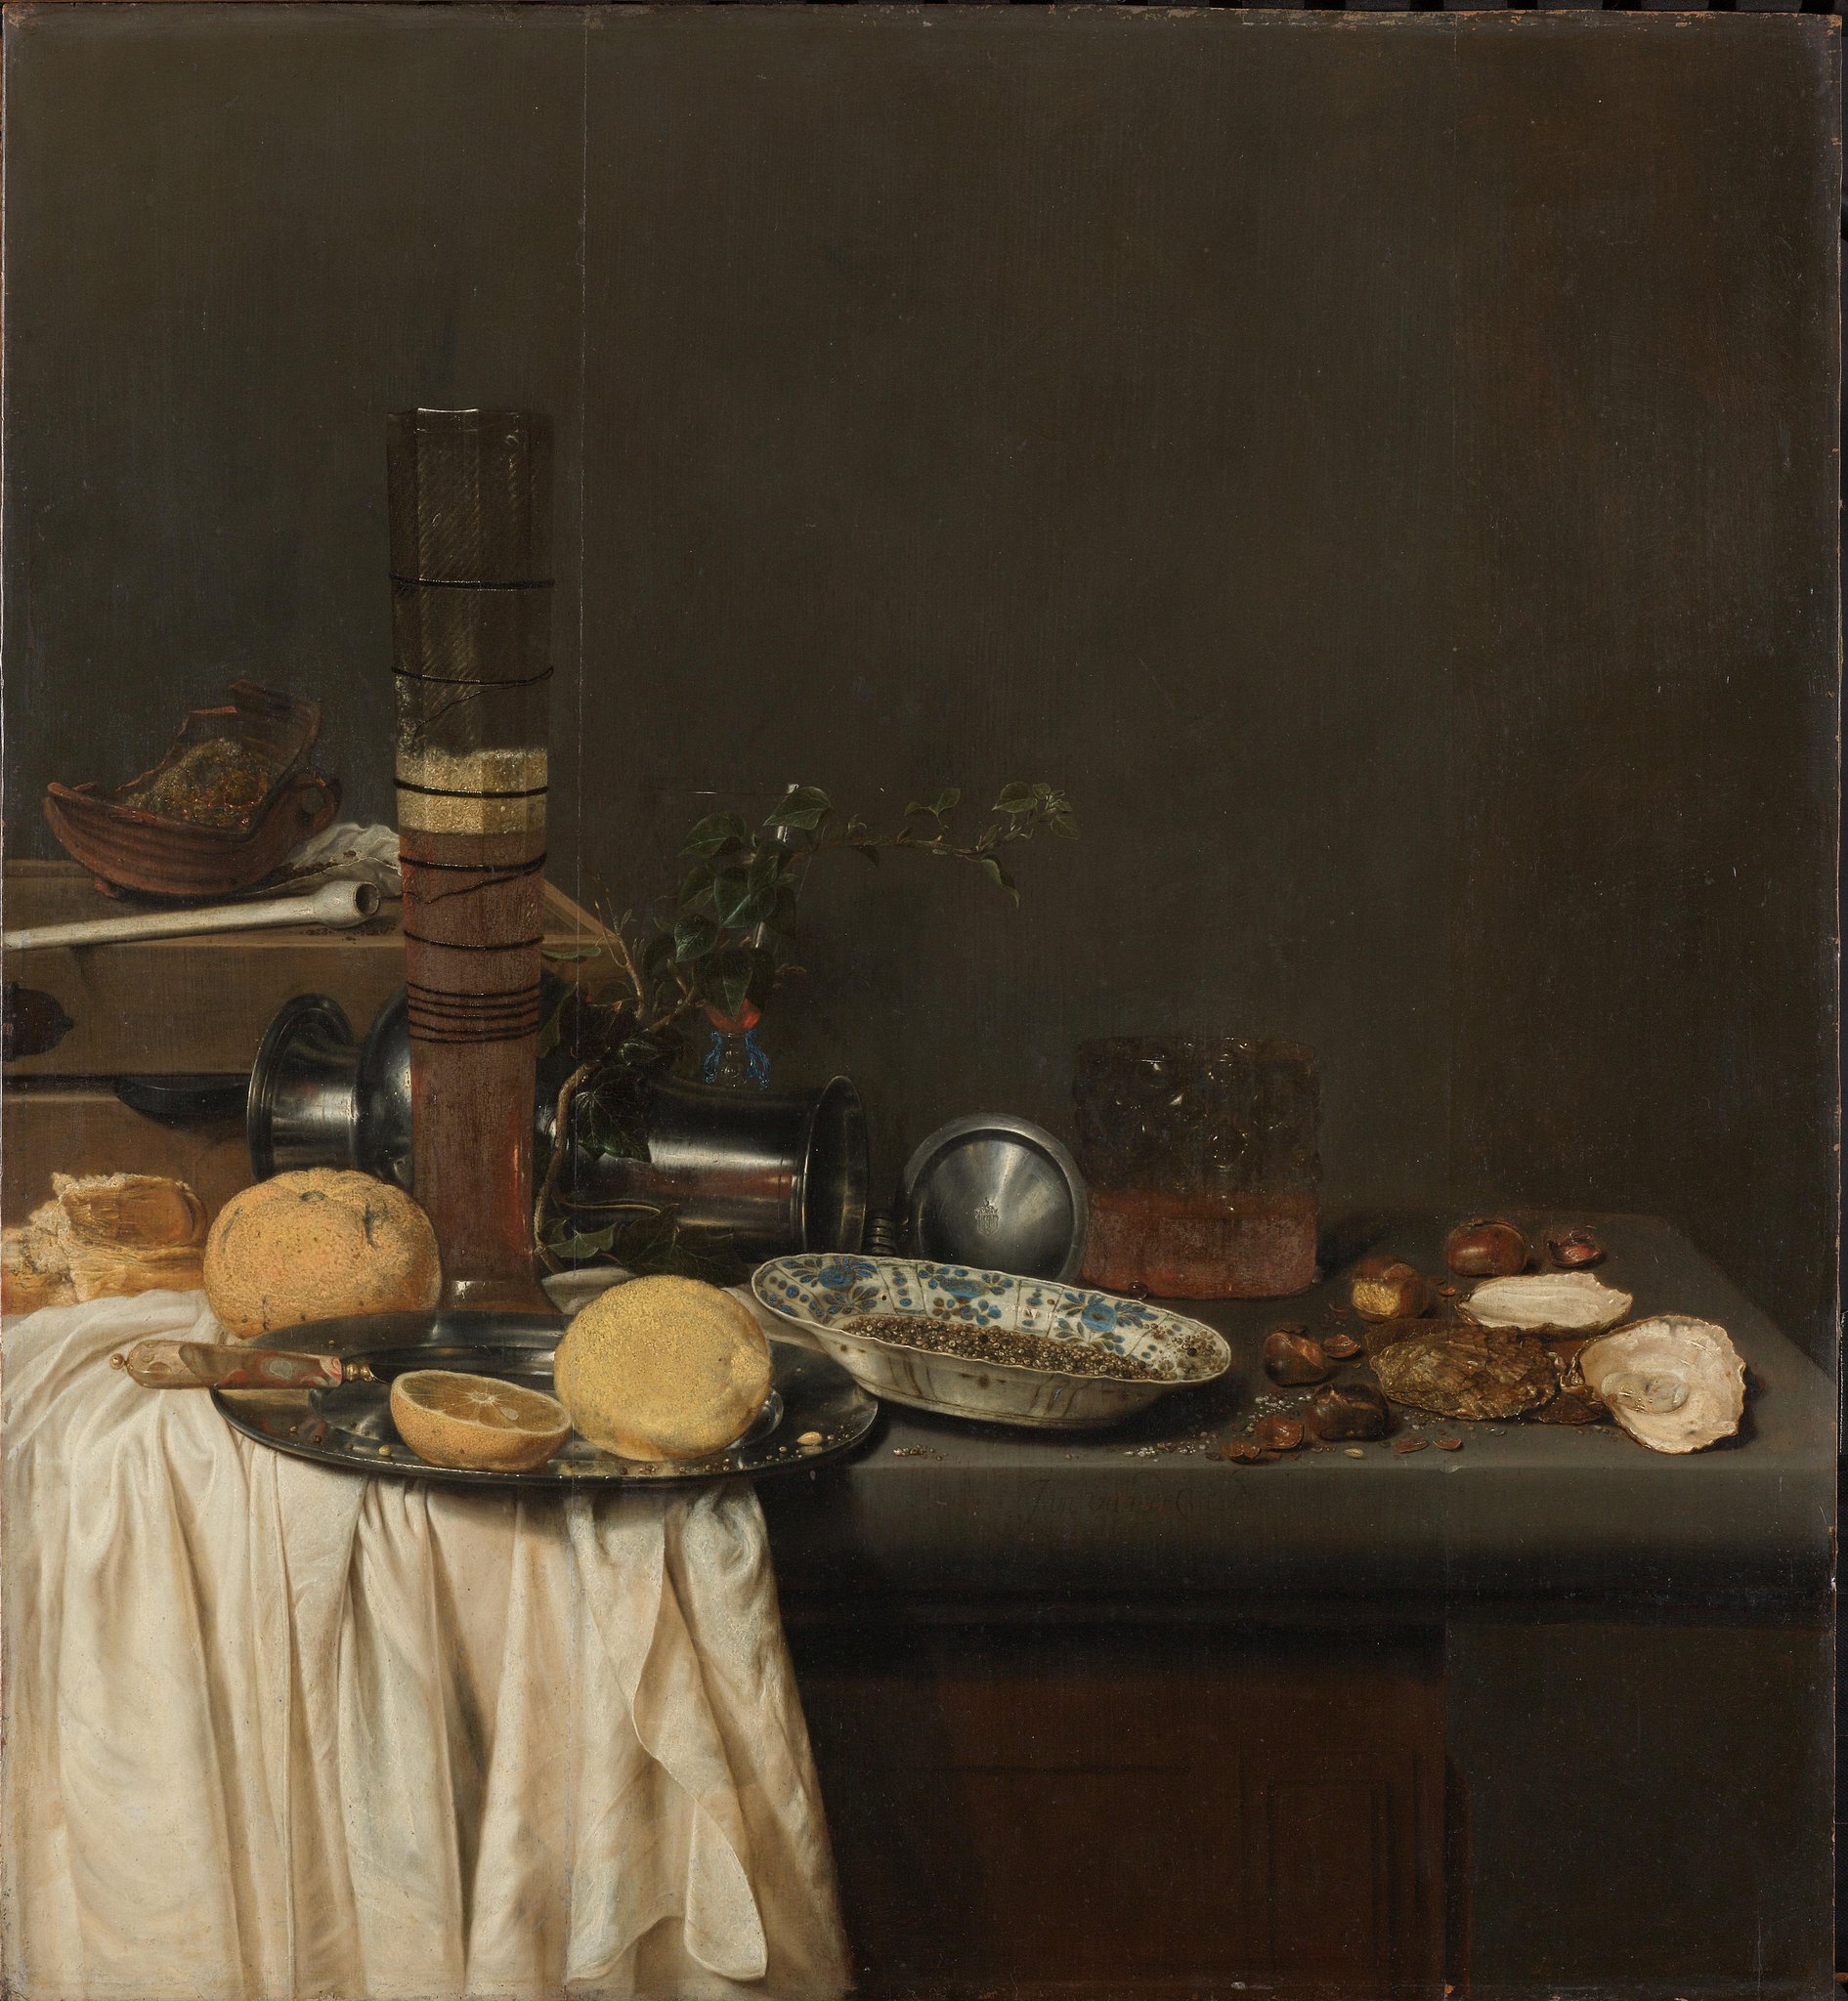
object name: painting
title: Still Life with a Beer Glass and a Porcelain Dish with Pepper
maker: jan jansz. van de velde (iii)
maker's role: painter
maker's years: 1619-1662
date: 1647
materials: oil, panel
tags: molluscs: oyster, laid table as still life, tobacco, glass of beer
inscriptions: signature and date: ‘Jan van de Velde 1647’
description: The porcelain dish is surrounded by other objects that bear witness to Dutch taste in the 17th century. It holds pepper, an expensive product that not everyone could afford. A hallmark in the form of the arms of Amsterdam is stamped on the lid of the jug, alluding to the city’s key role as a centre of trade.